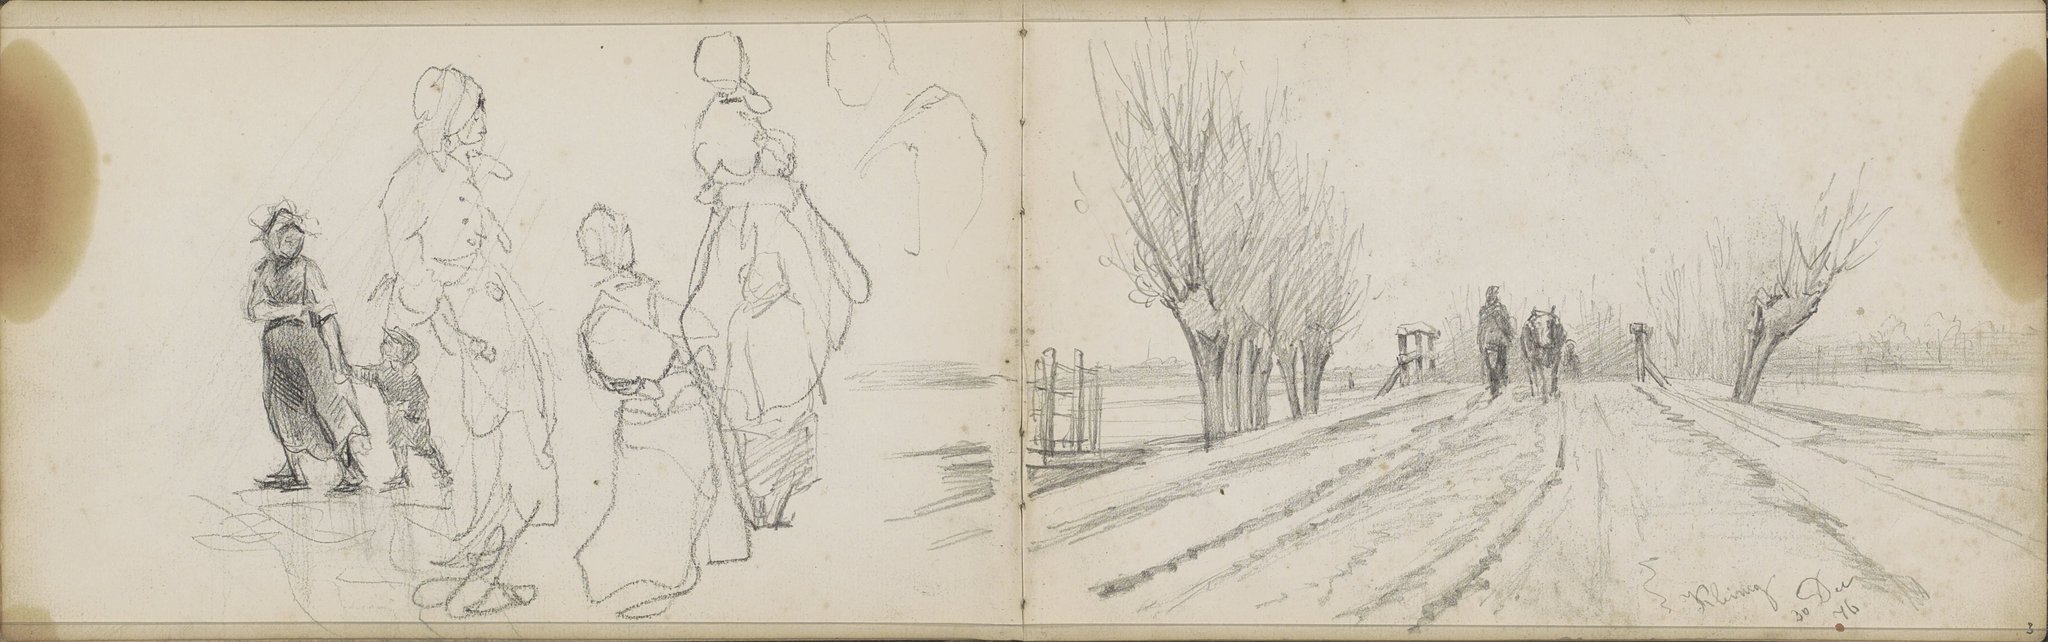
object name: sketchbook leaf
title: Figuurstudies en de Kleiweg bij Rotterdam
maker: willem cornelis rip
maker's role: draughtsman, painter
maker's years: 1856-1922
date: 1812-1876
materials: paper, pencil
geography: rotterdam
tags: child, road, path, trees: willow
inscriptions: date and inscription: ‘Kleiweg/ 30 Dec/ 76’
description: Op de Kleiweg loopt een figuur met een koe. Langs de weg staan knotwilgen. Blad 2 verso en 3 recto uit een schetsboek met 41 bladen.